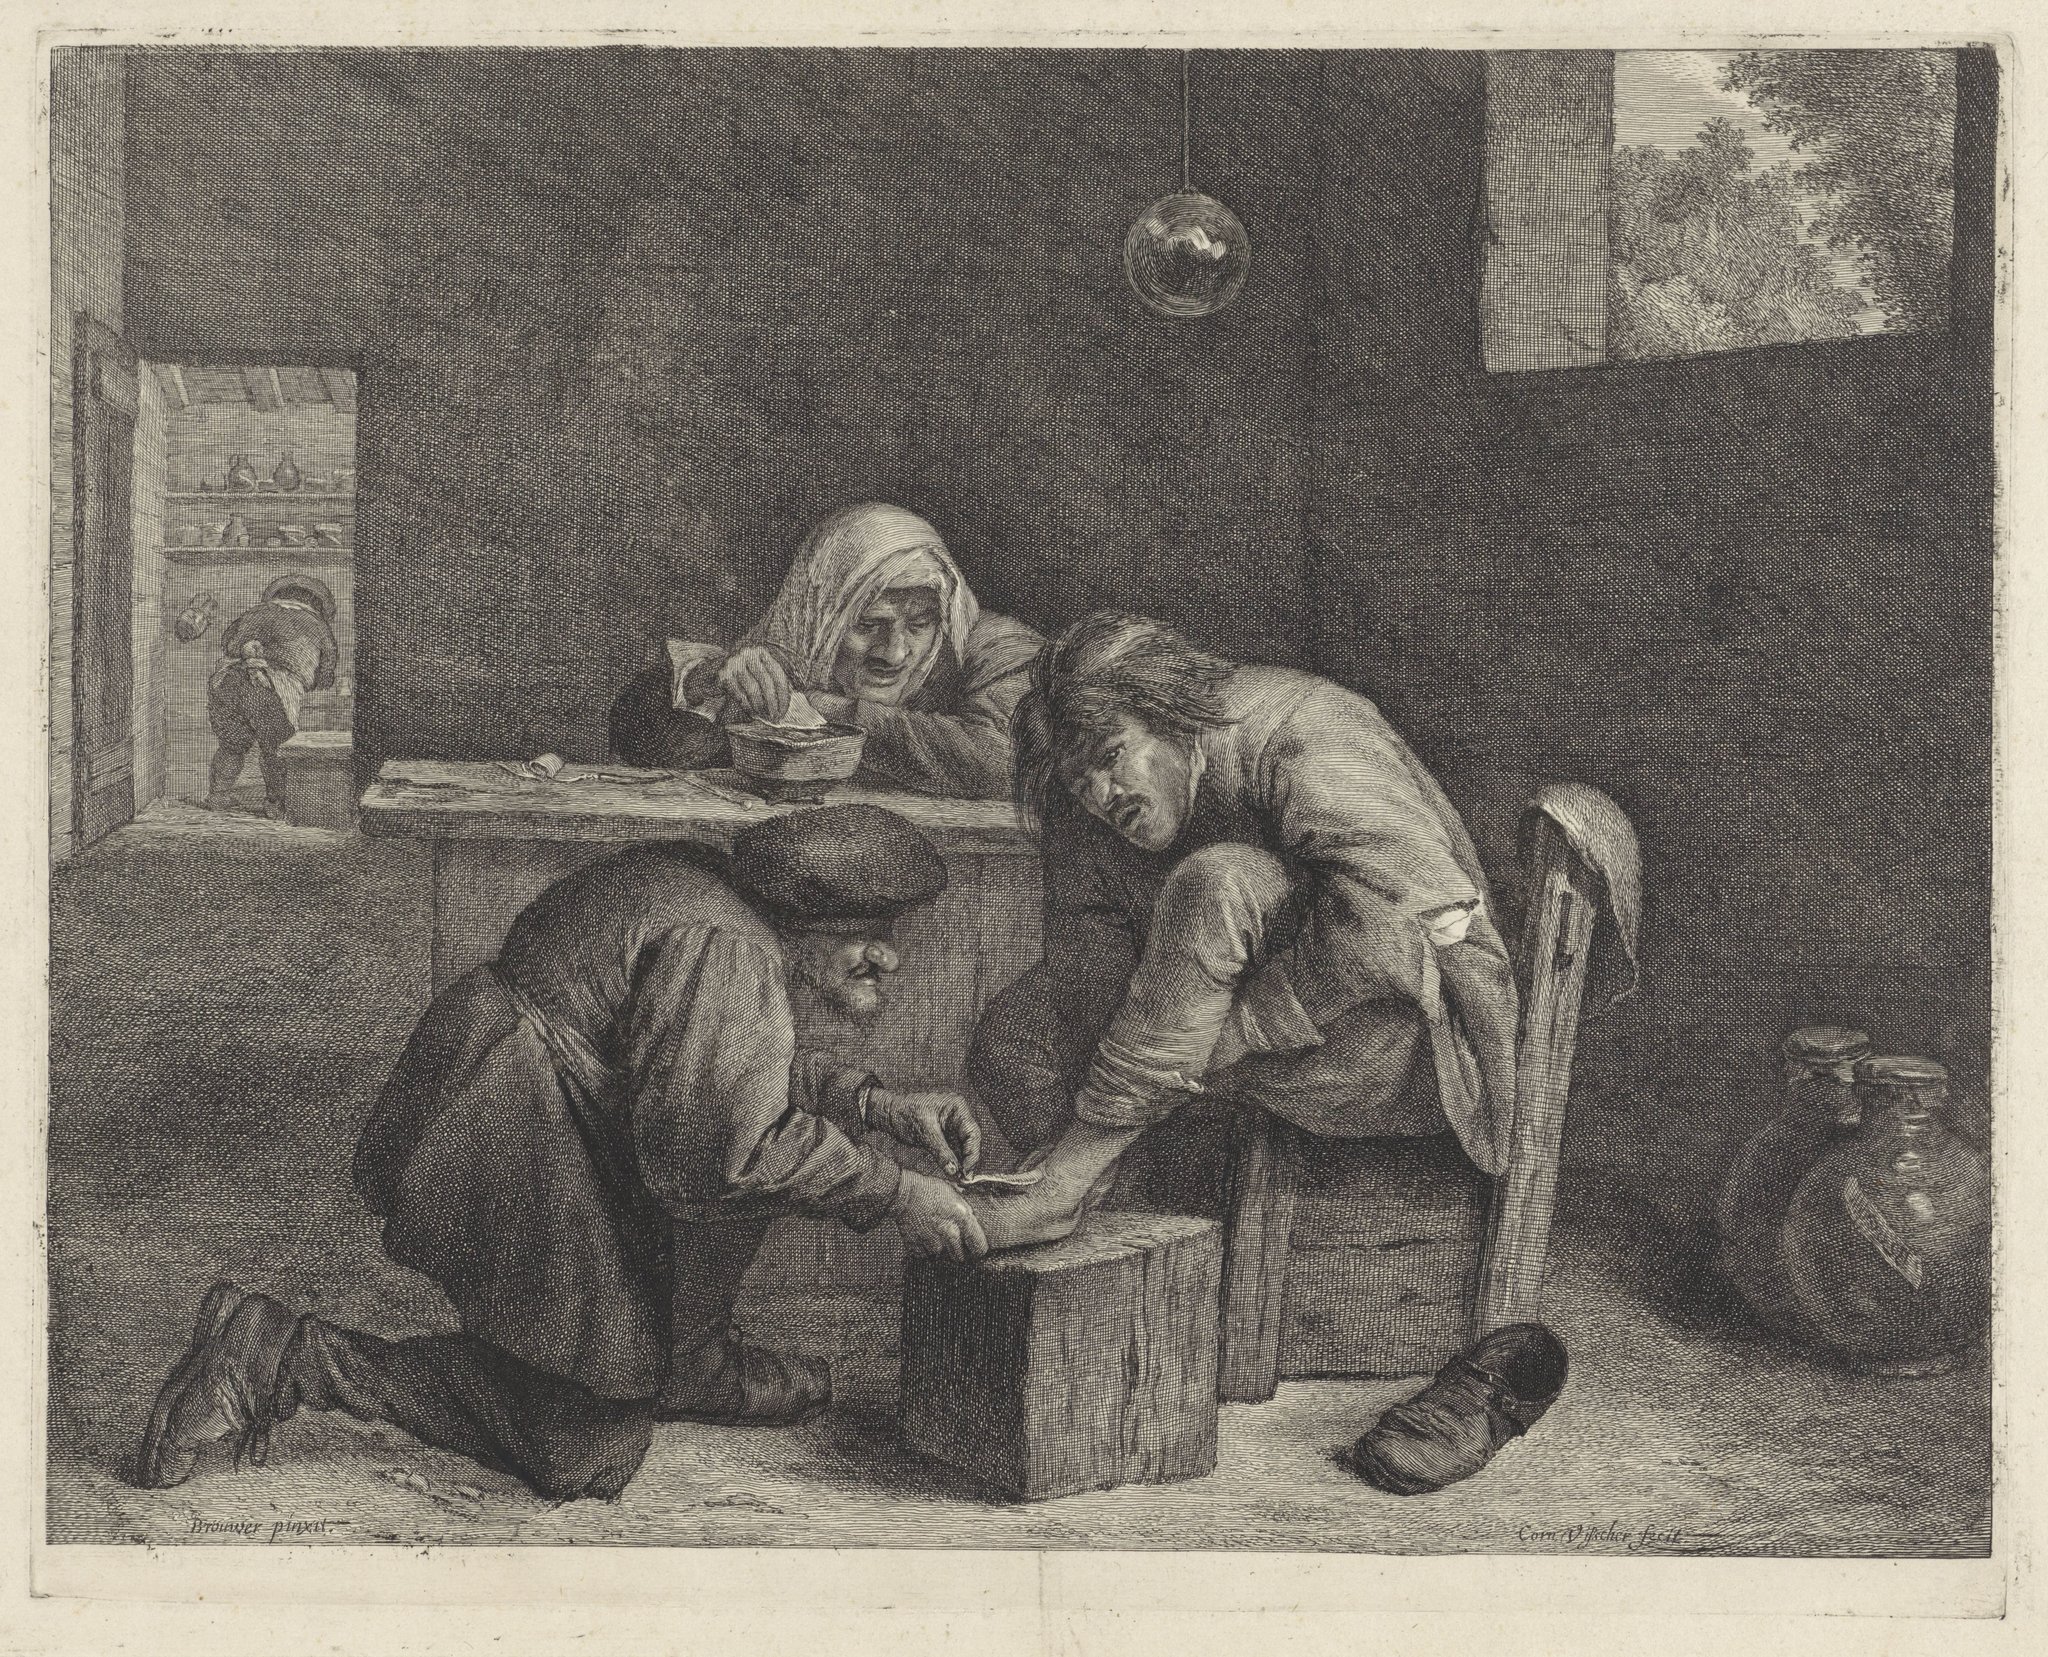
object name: print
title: Man bij een arts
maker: adriaen brouwer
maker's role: draughtsman, painter, print maker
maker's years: 1605-1638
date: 1638-1658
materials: paper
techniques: engraving, etching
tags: physician, doctor, care of hands and feet, medical examination, medical treatment, pain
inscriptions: collector's mark: Lugt 240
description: In een vertrek verzorgt of opereert een arts de voet van een man die in een stoel zit en zijn voet op een blok hout laat rusten. De patiënt trekt een gepijnigd gezicht. Een tweede man observeert de behandeling vanachter zijn tafel. Op de achtergrond een man in een opslagruimte.